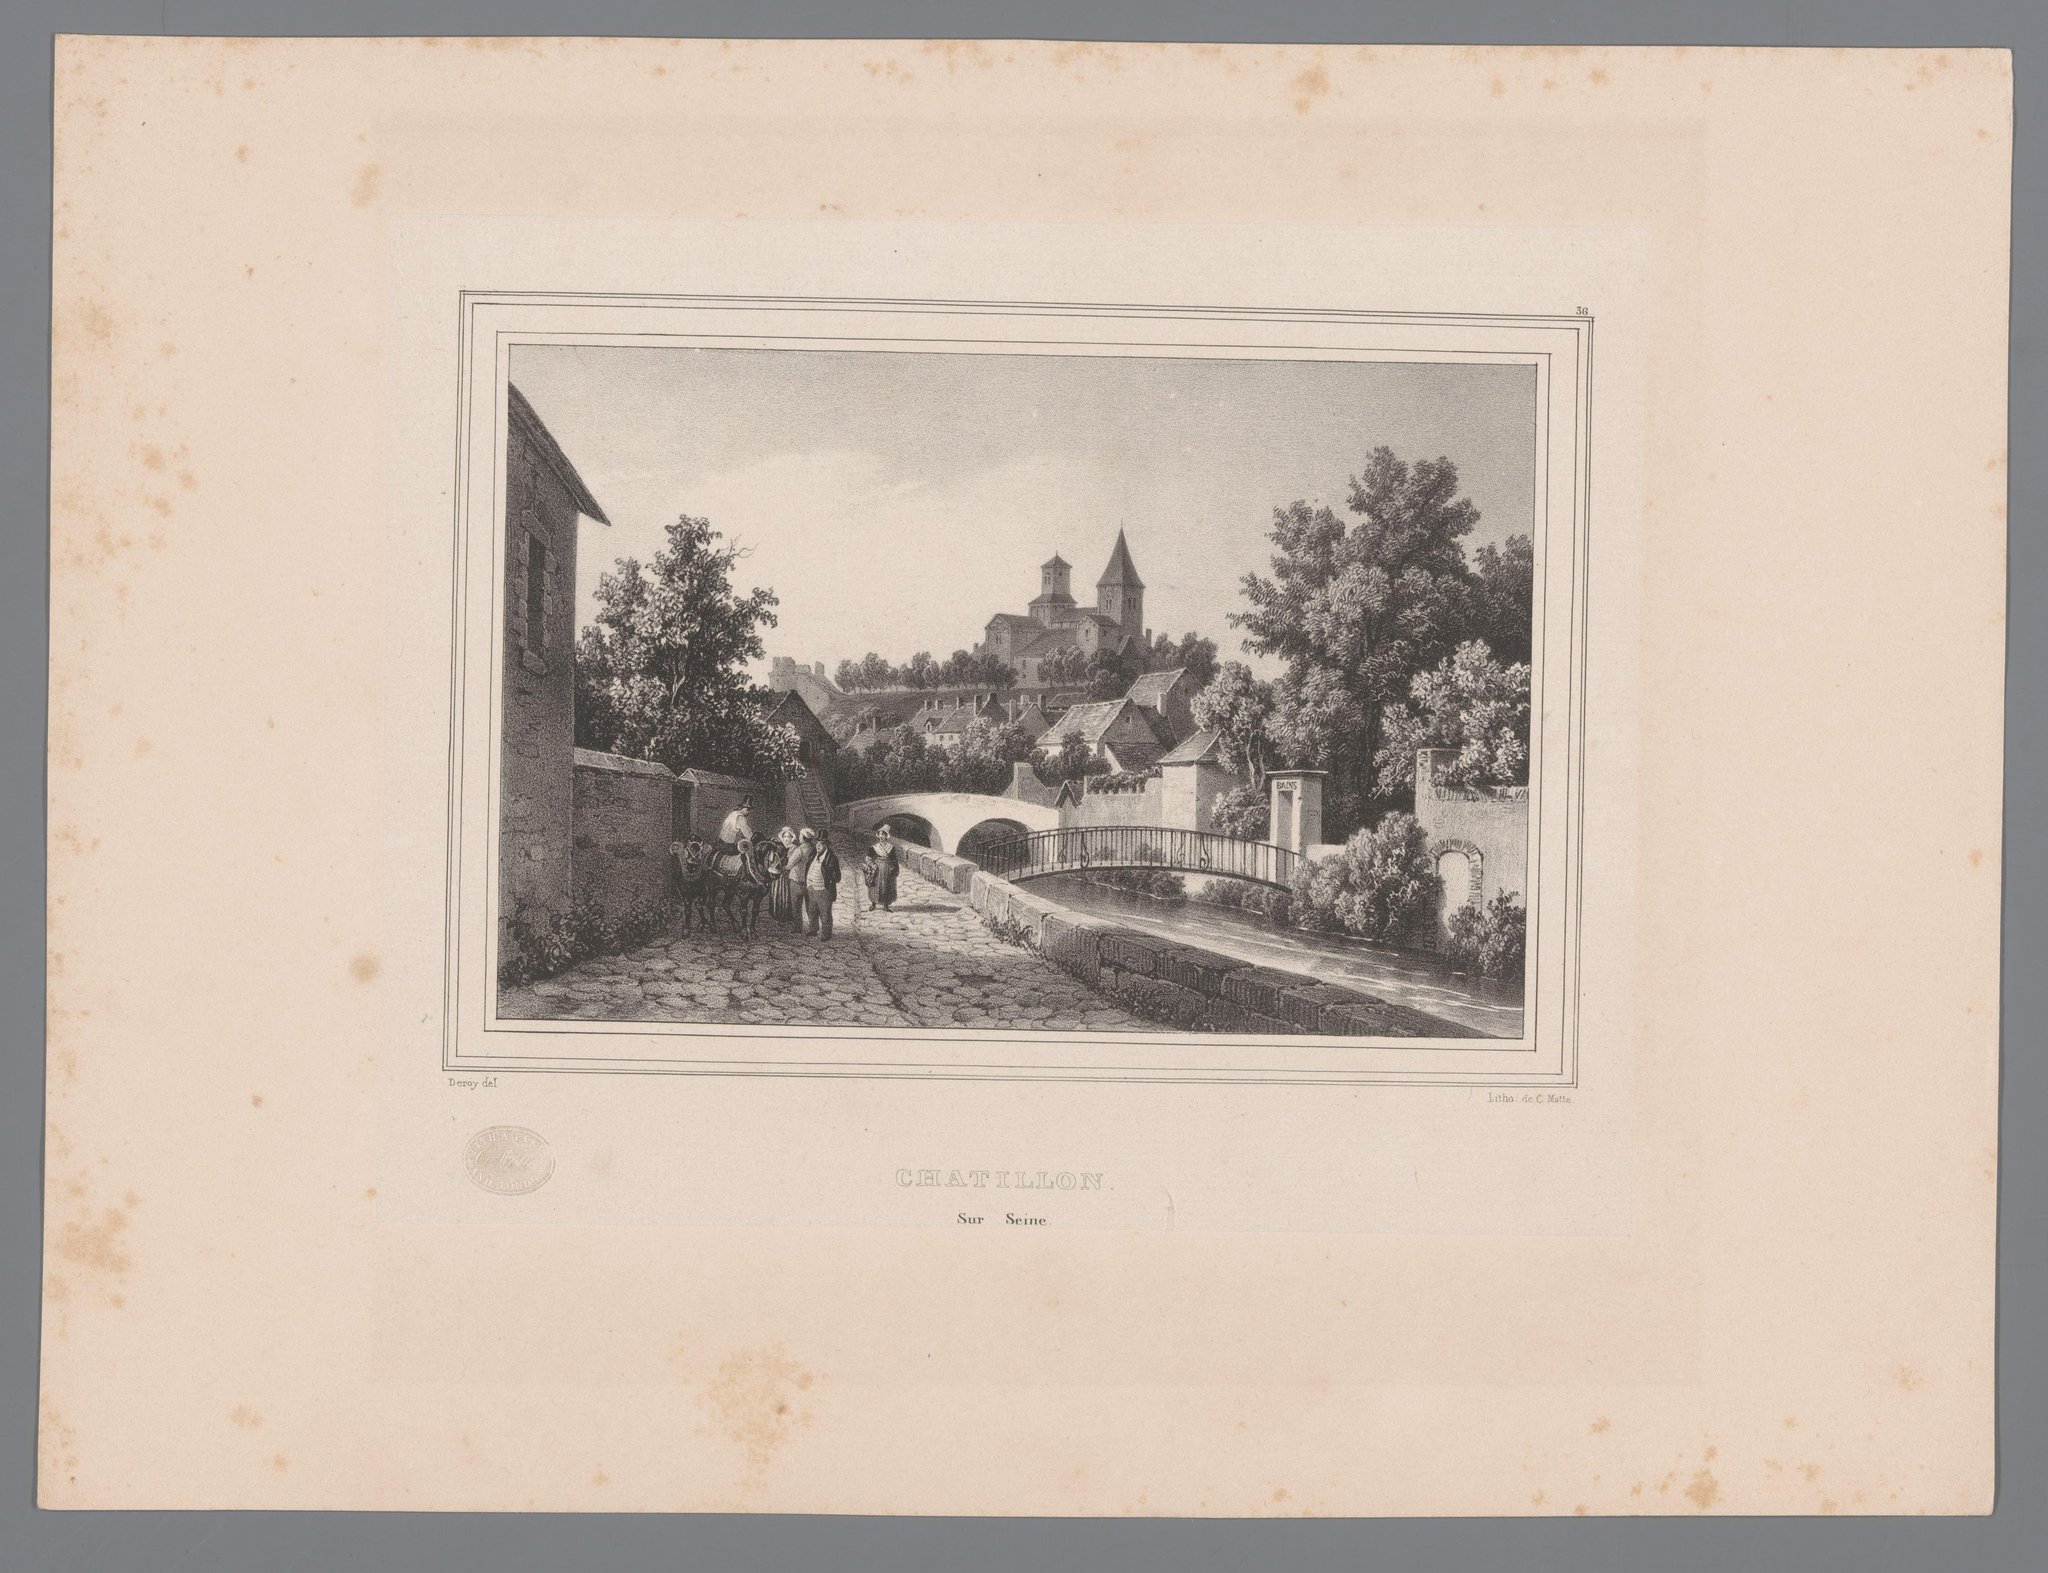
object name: print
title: Gezichten aan de oevers van de Seine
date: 1829-1831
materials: paper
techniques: lithograph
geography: châtillon-sur-seine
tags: bridge in city across river, canal, etc., river (+ landscape with figures, staffage), prospect of city, town panorama, silhouette of city (+ city(-scape) with figures, staffage)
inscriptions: collector's mark: Lugt 2228a, check stamp: Lugt 1828b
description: Prent maakt deel uit van een omslag met dertien prenten.